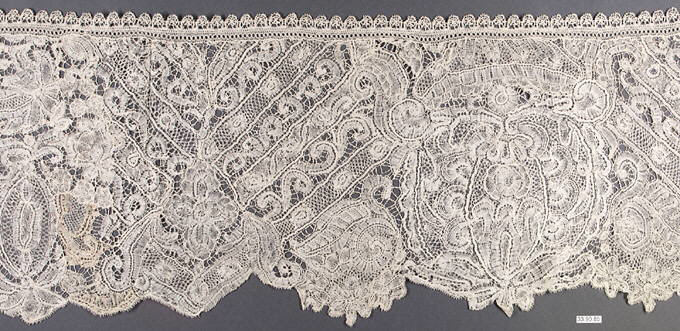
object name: flounce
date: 1701-1733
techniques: lace